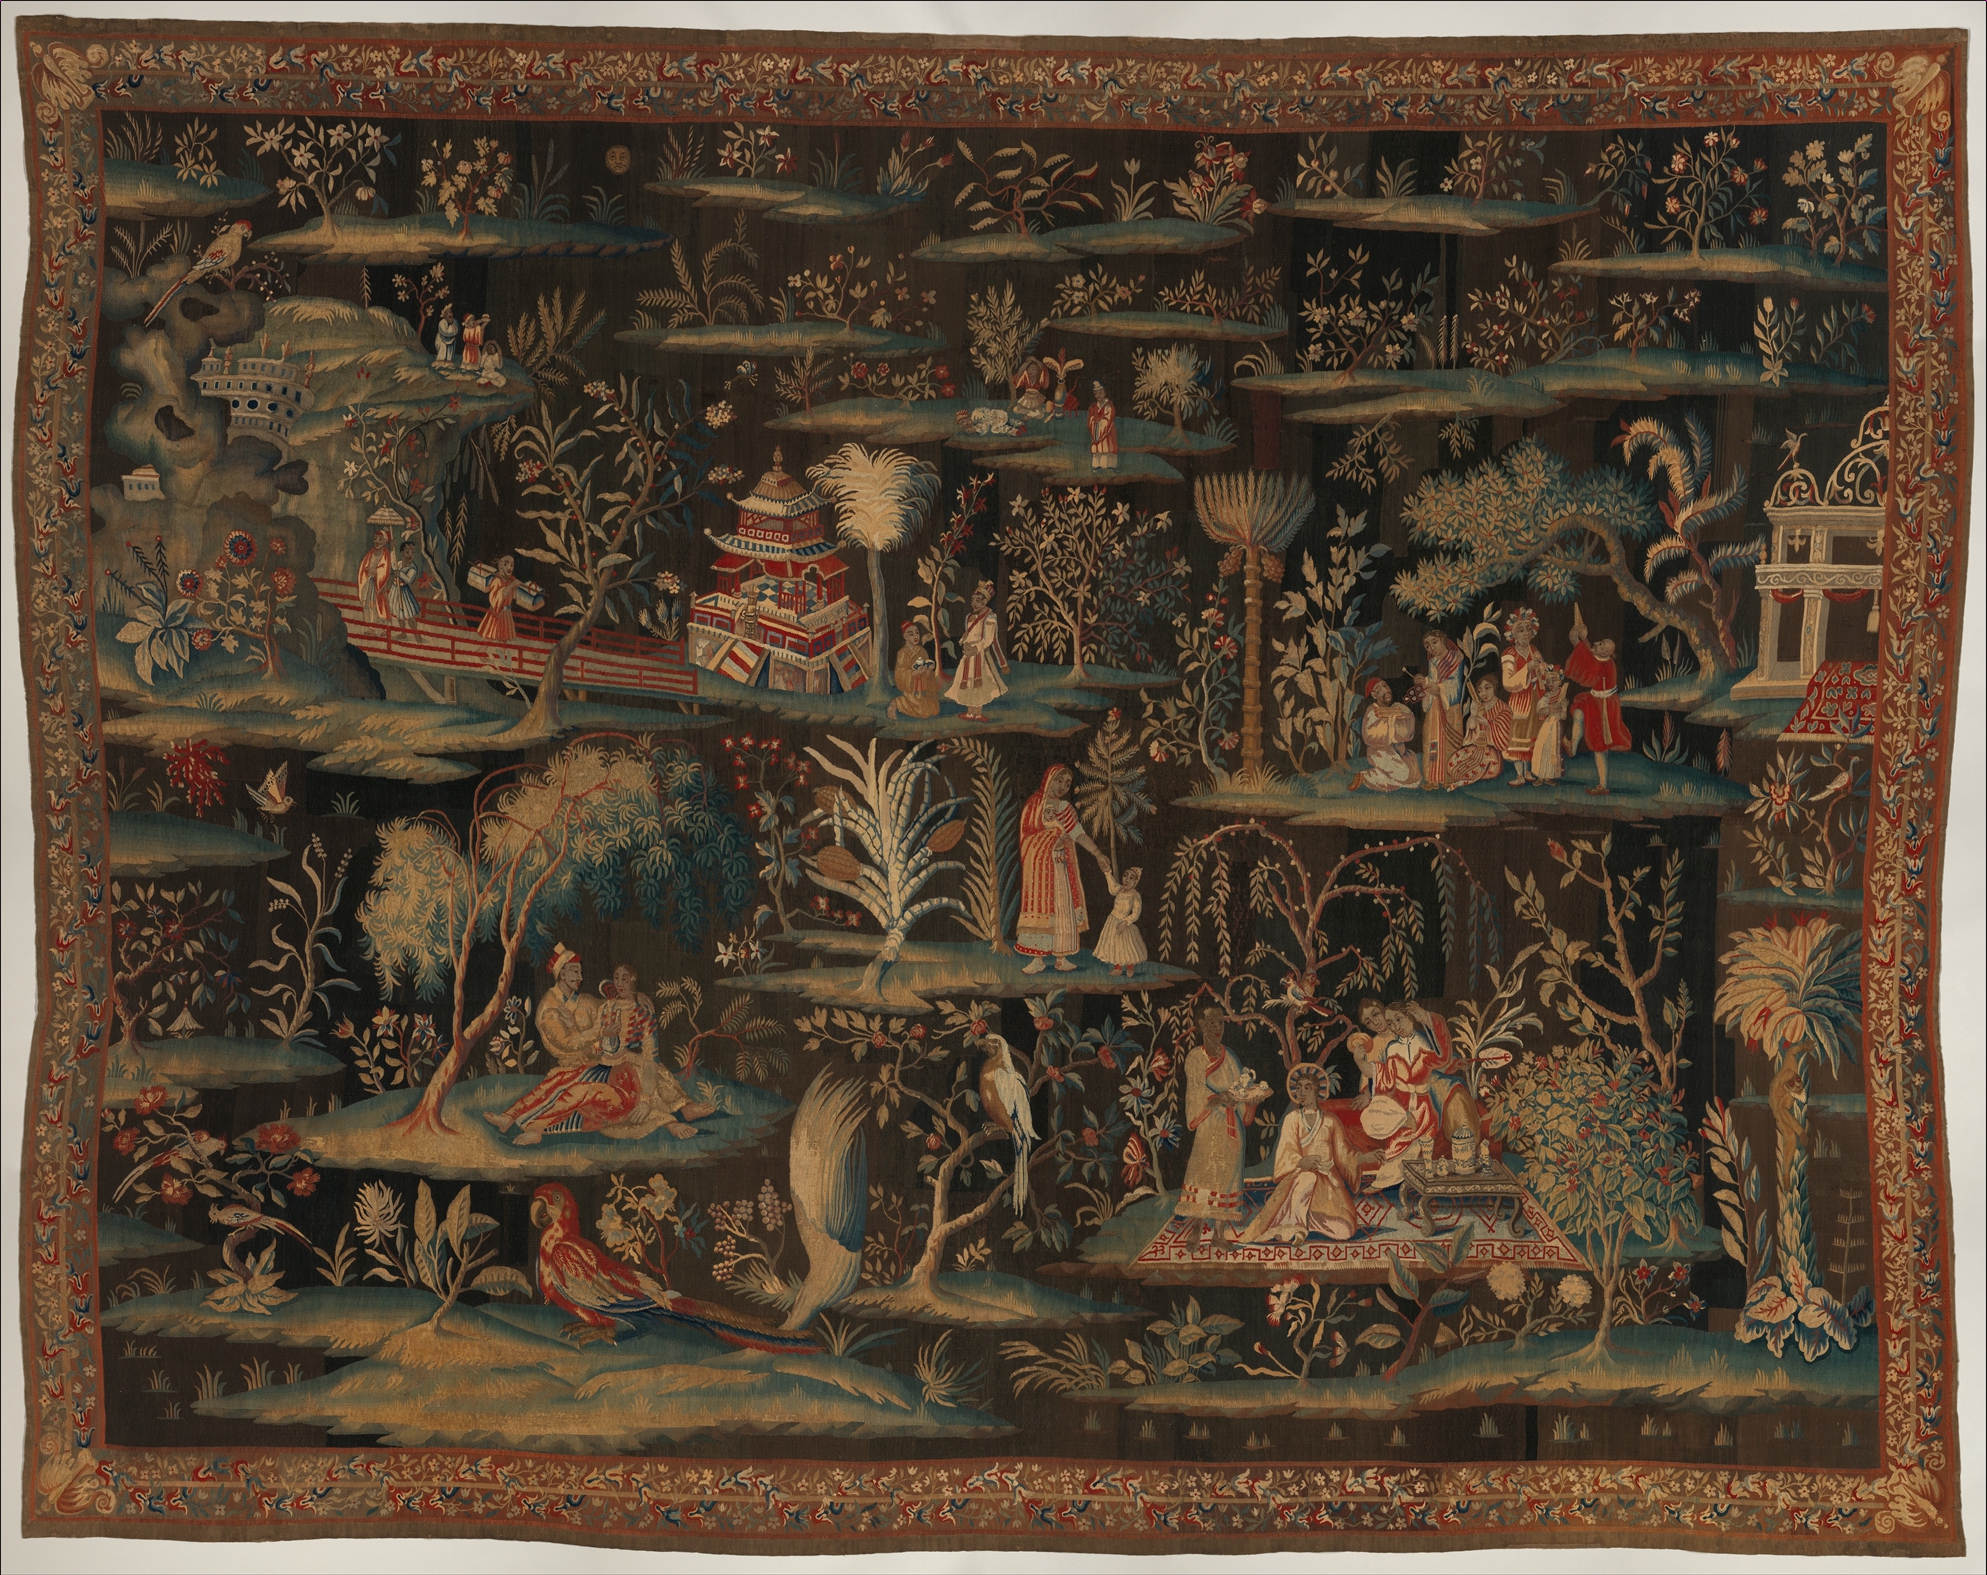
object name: tapestry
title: The Toilette of the Princess from a set of Tapestries "After the Indian Manner"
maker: john vanderbank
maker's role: maker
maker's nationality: flemish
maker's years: 1683-1717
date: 1690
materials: silk, wool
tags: chinoiserie,men,women,parrots,flowers